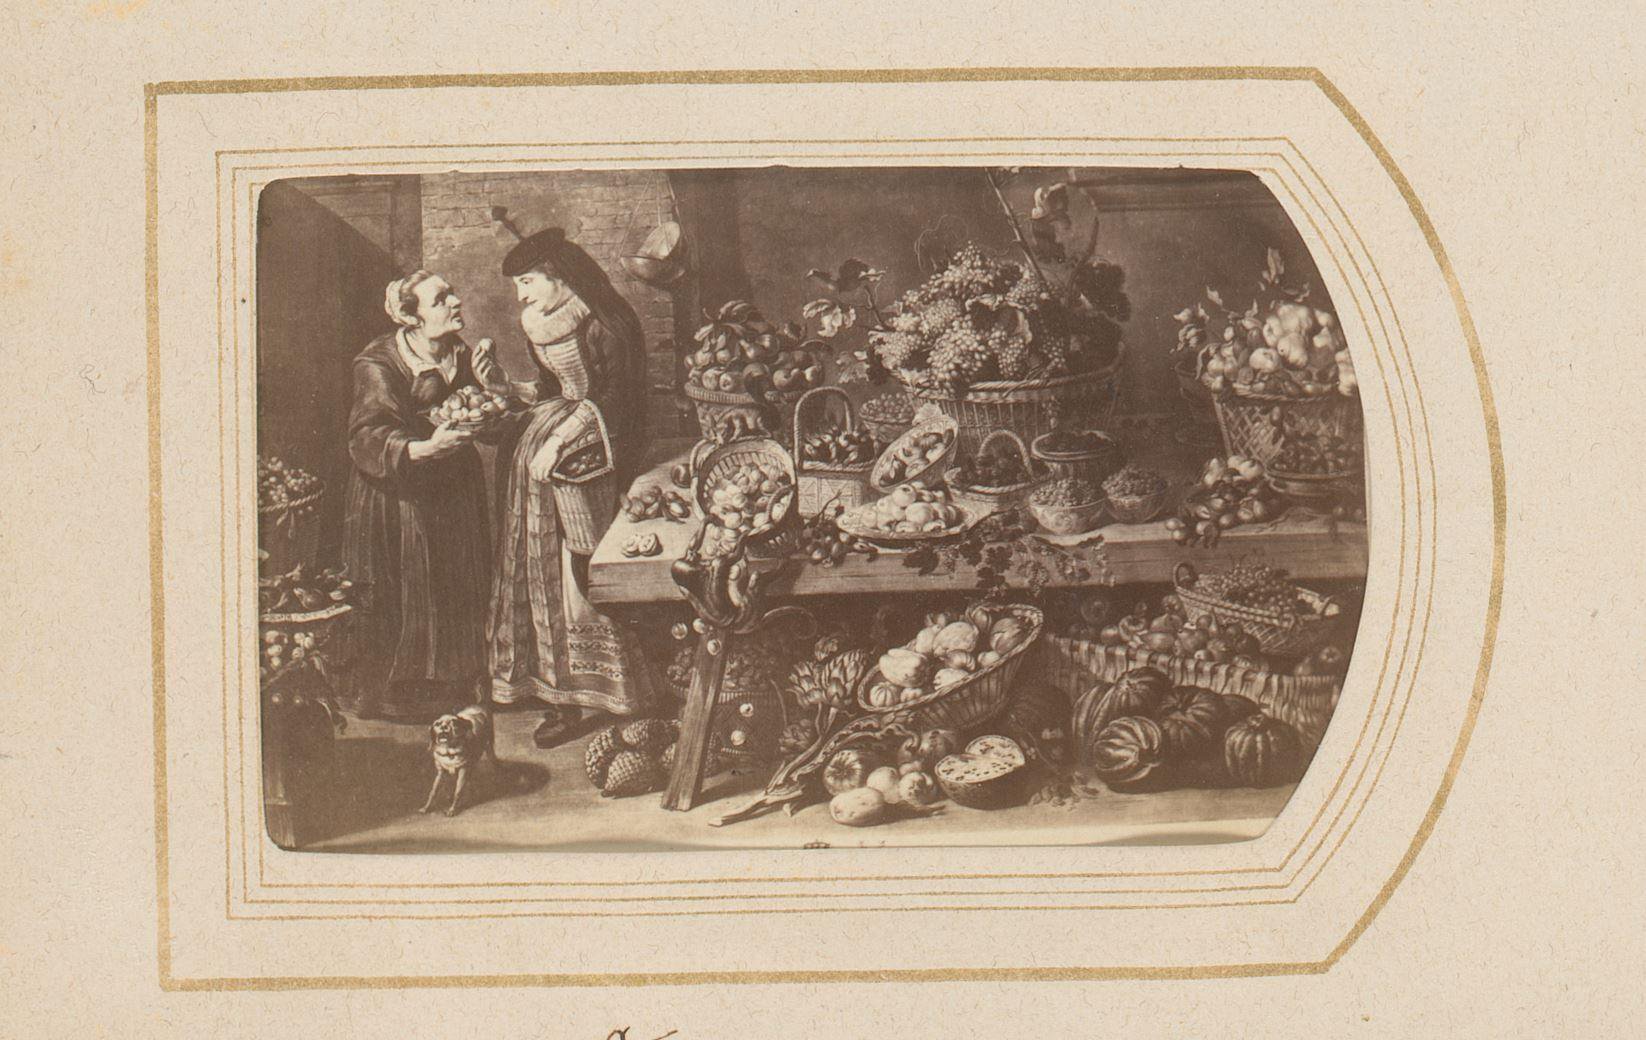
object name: album leaf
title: Fotoreproductie van Marktstuk door Frans Snijders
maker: Anonymous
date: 1870-1890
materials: cardboard, photographic support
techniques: albumen print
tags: stall, booth (~ market), fruits, painting, drawing and the graphic arts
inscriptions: number: ‘2094’, annotation: ‘Fruchtmarkt’